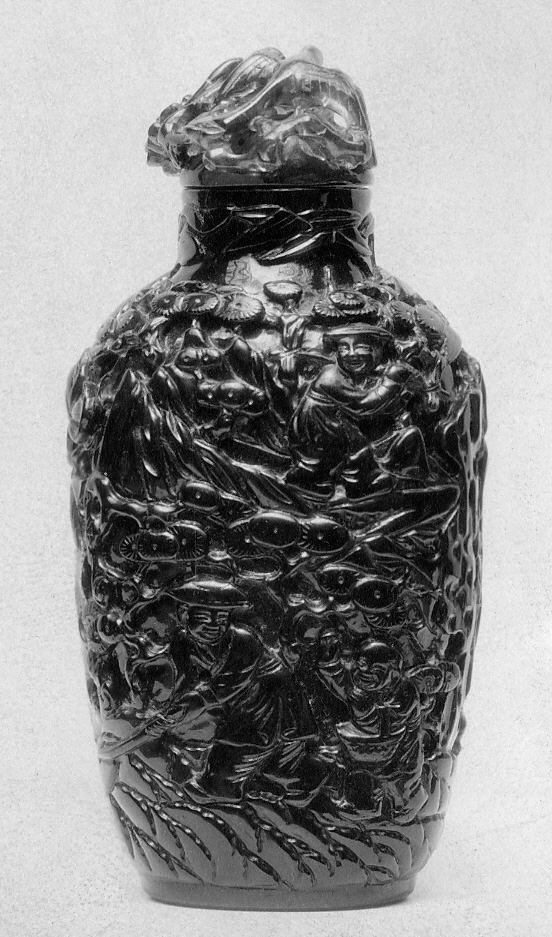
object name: snuff bottle with stopper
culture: chinese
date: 1736-1795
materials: amber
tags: human figures